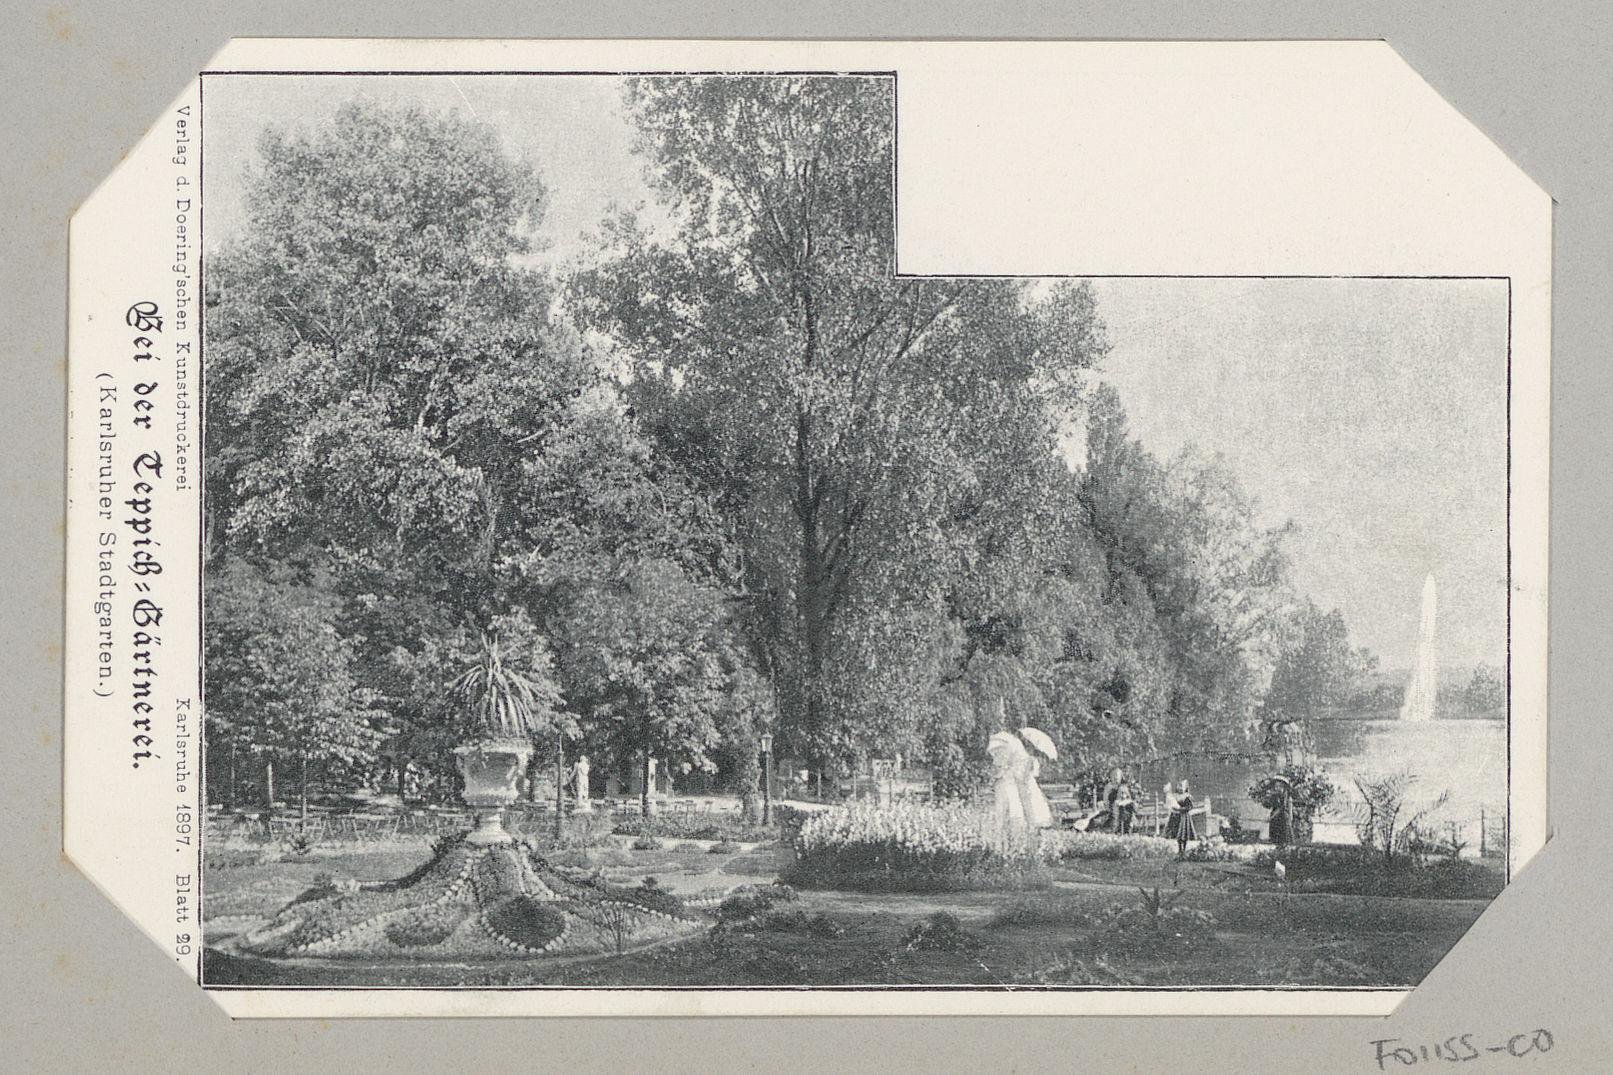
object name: album leaf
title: Gezicht op een stadspark te Karlsruhe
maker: Anonymous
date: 1897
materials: paper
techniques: autotype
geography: karlsruhe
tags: public gardens, park (+ city(-scape) with figures, staffage)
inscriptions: inscription: ‘Verlag d. Doering'schen Kunstdruckerei/ Karlsruhe 1897. Blatt 29/ Bei der Teppich=Gärtnerei/ (Karlsruhe Stadtgarten.)’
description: Deze prent maakt deel uit van een album.